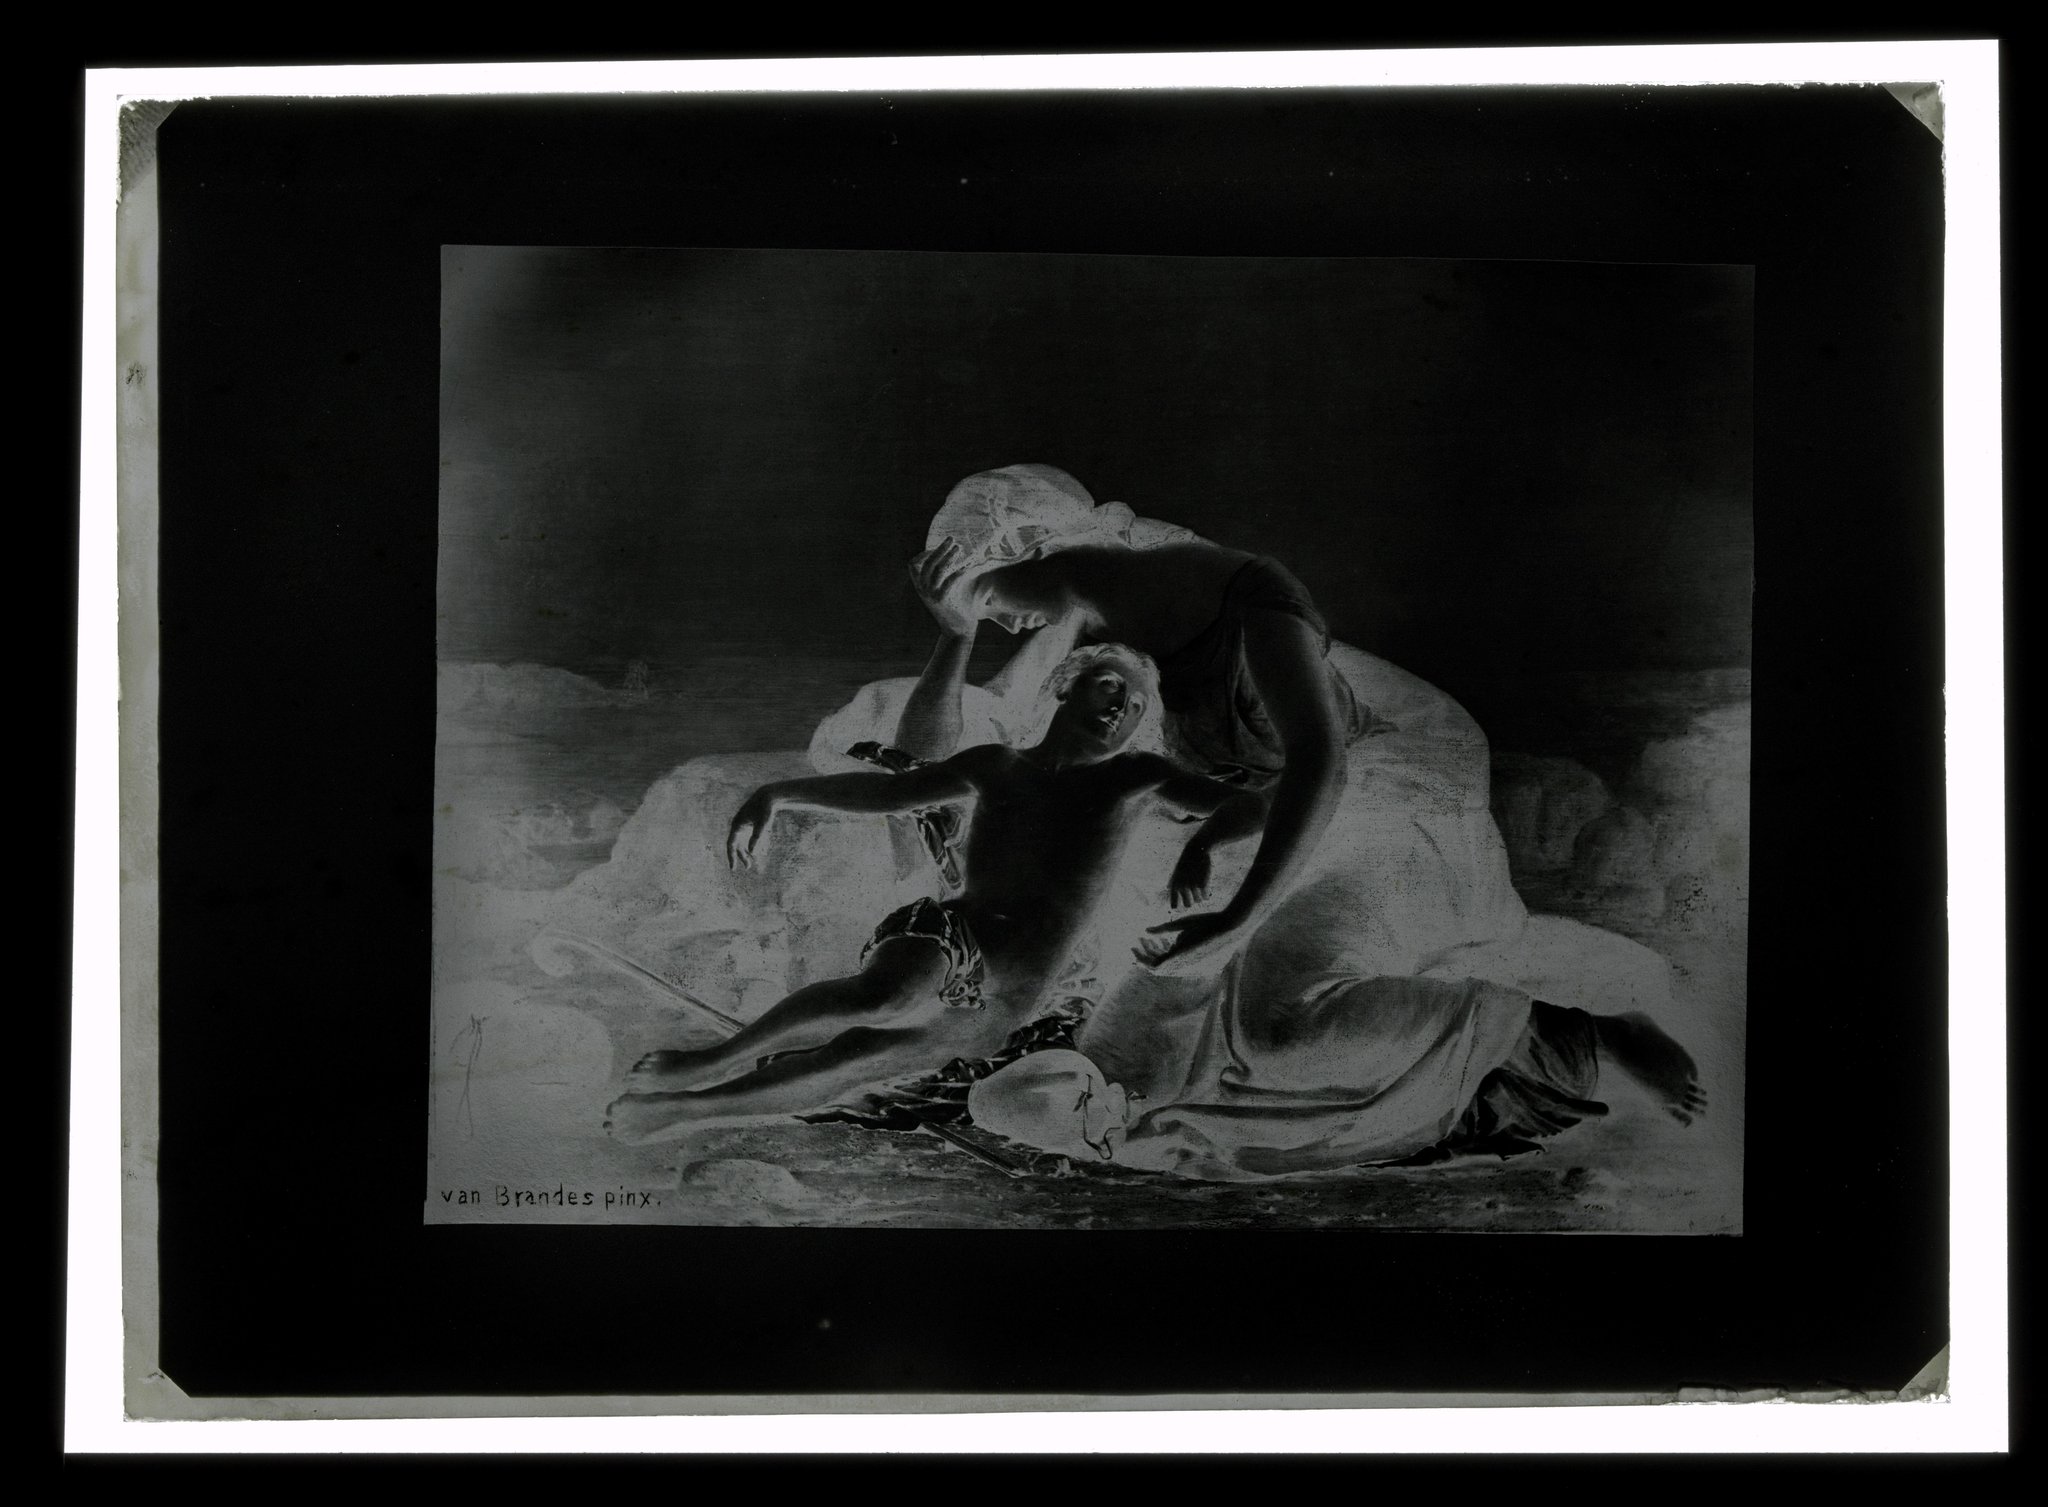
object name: glasnegatief, glasplaatnegatief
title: Fotoreproductie van een schilderij van een vrouw met jongen, door Laurens Lodewijk Kleijn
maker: laurens lodewijk kleijn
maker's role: draughtsman, painter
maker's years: 1826-1909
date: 1865-1900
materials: glass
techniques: collodion process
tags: mother and child(ren), woman and child(ren) (family group)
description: Onderdeel van een groep glasnegatieven uit de nalatenschap van de schilder Laurens Lodewijk Kleijn, met stillevens, portretten, zelfportretten en kunstreproducties.